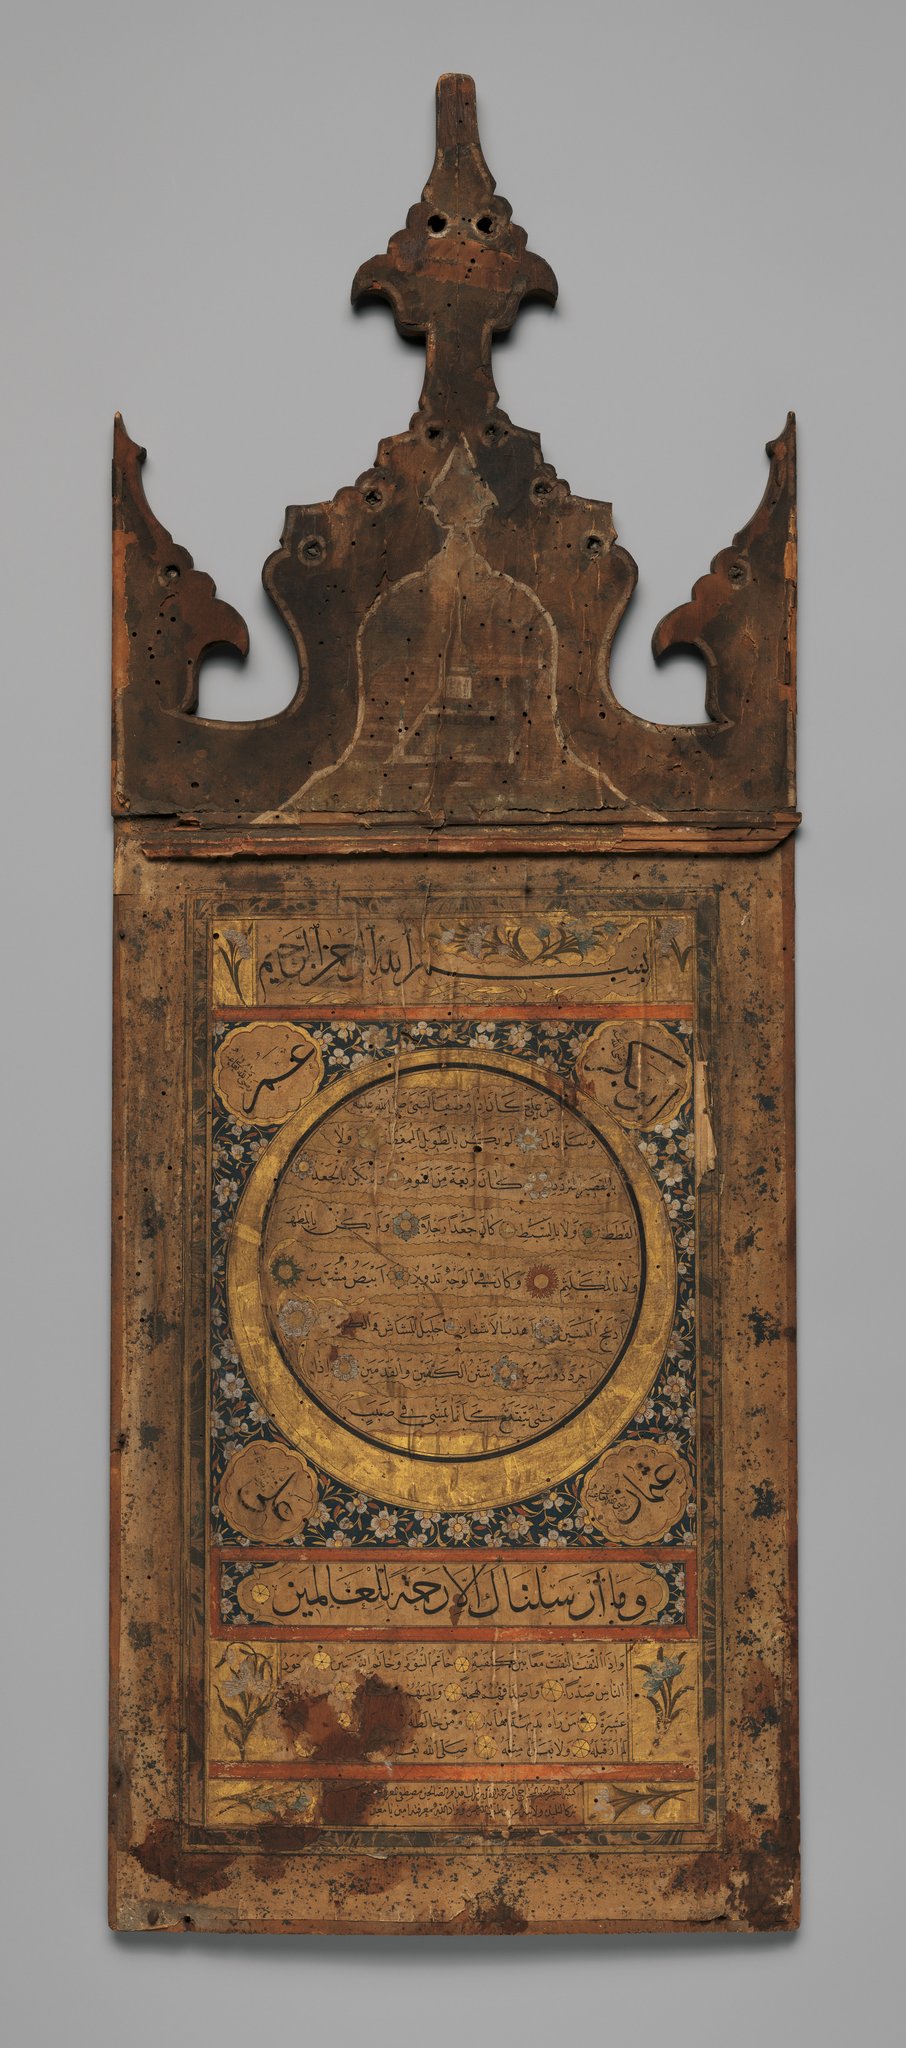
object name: votive tablet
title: Hilya (Votive Tablet)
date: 1701-1800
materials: gold, ink, paper, watercolor, wood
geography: turkey